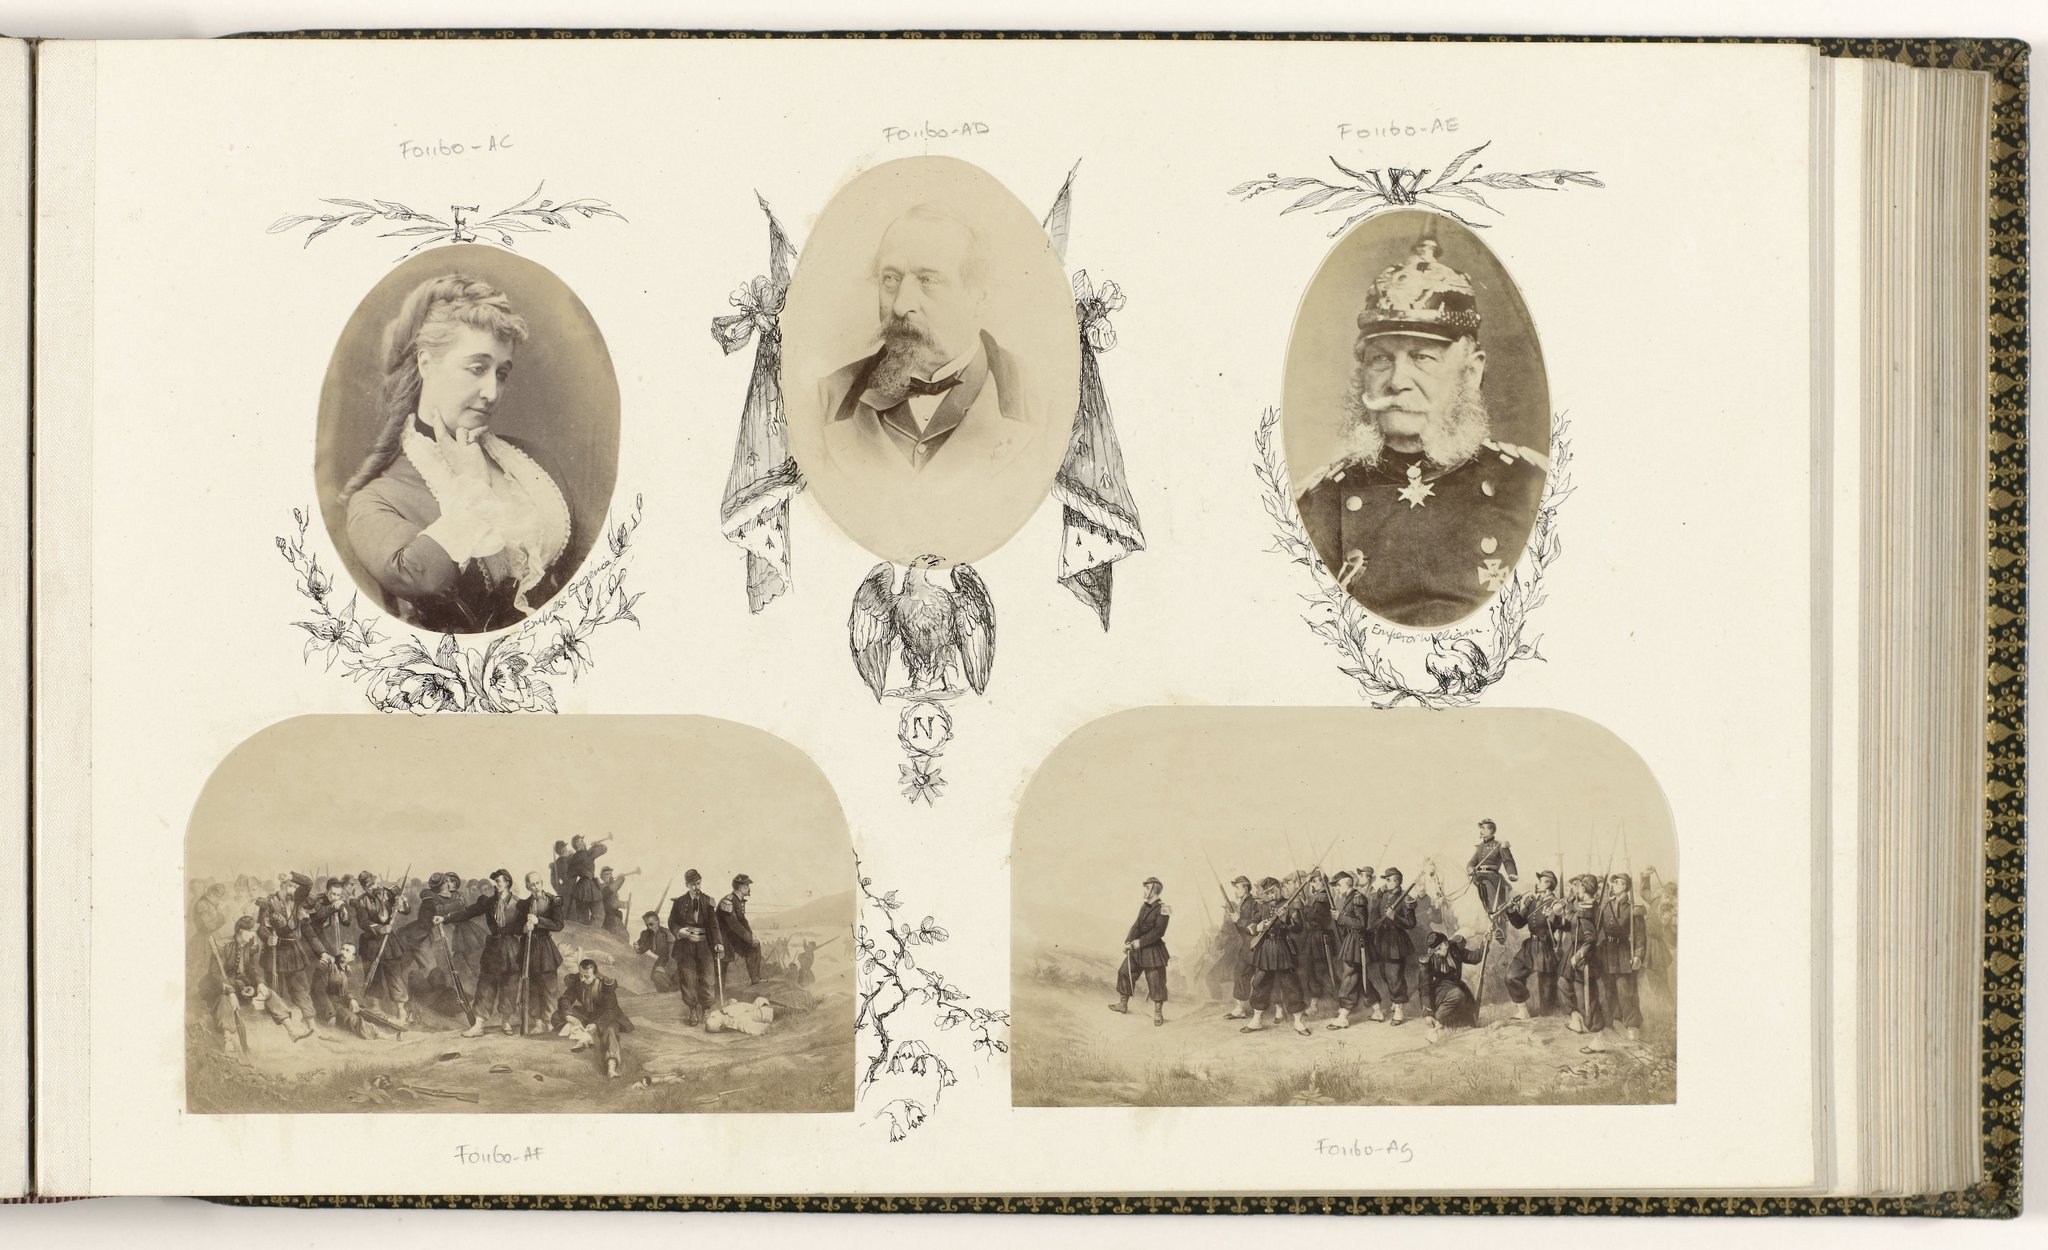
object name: photograph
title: Portret van keizer Napoleon III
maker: Anonymous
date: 1865-1875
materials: paper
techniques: albumen print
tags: paris, london, napoleon iii (keizer der fransen), historical persons, emperor